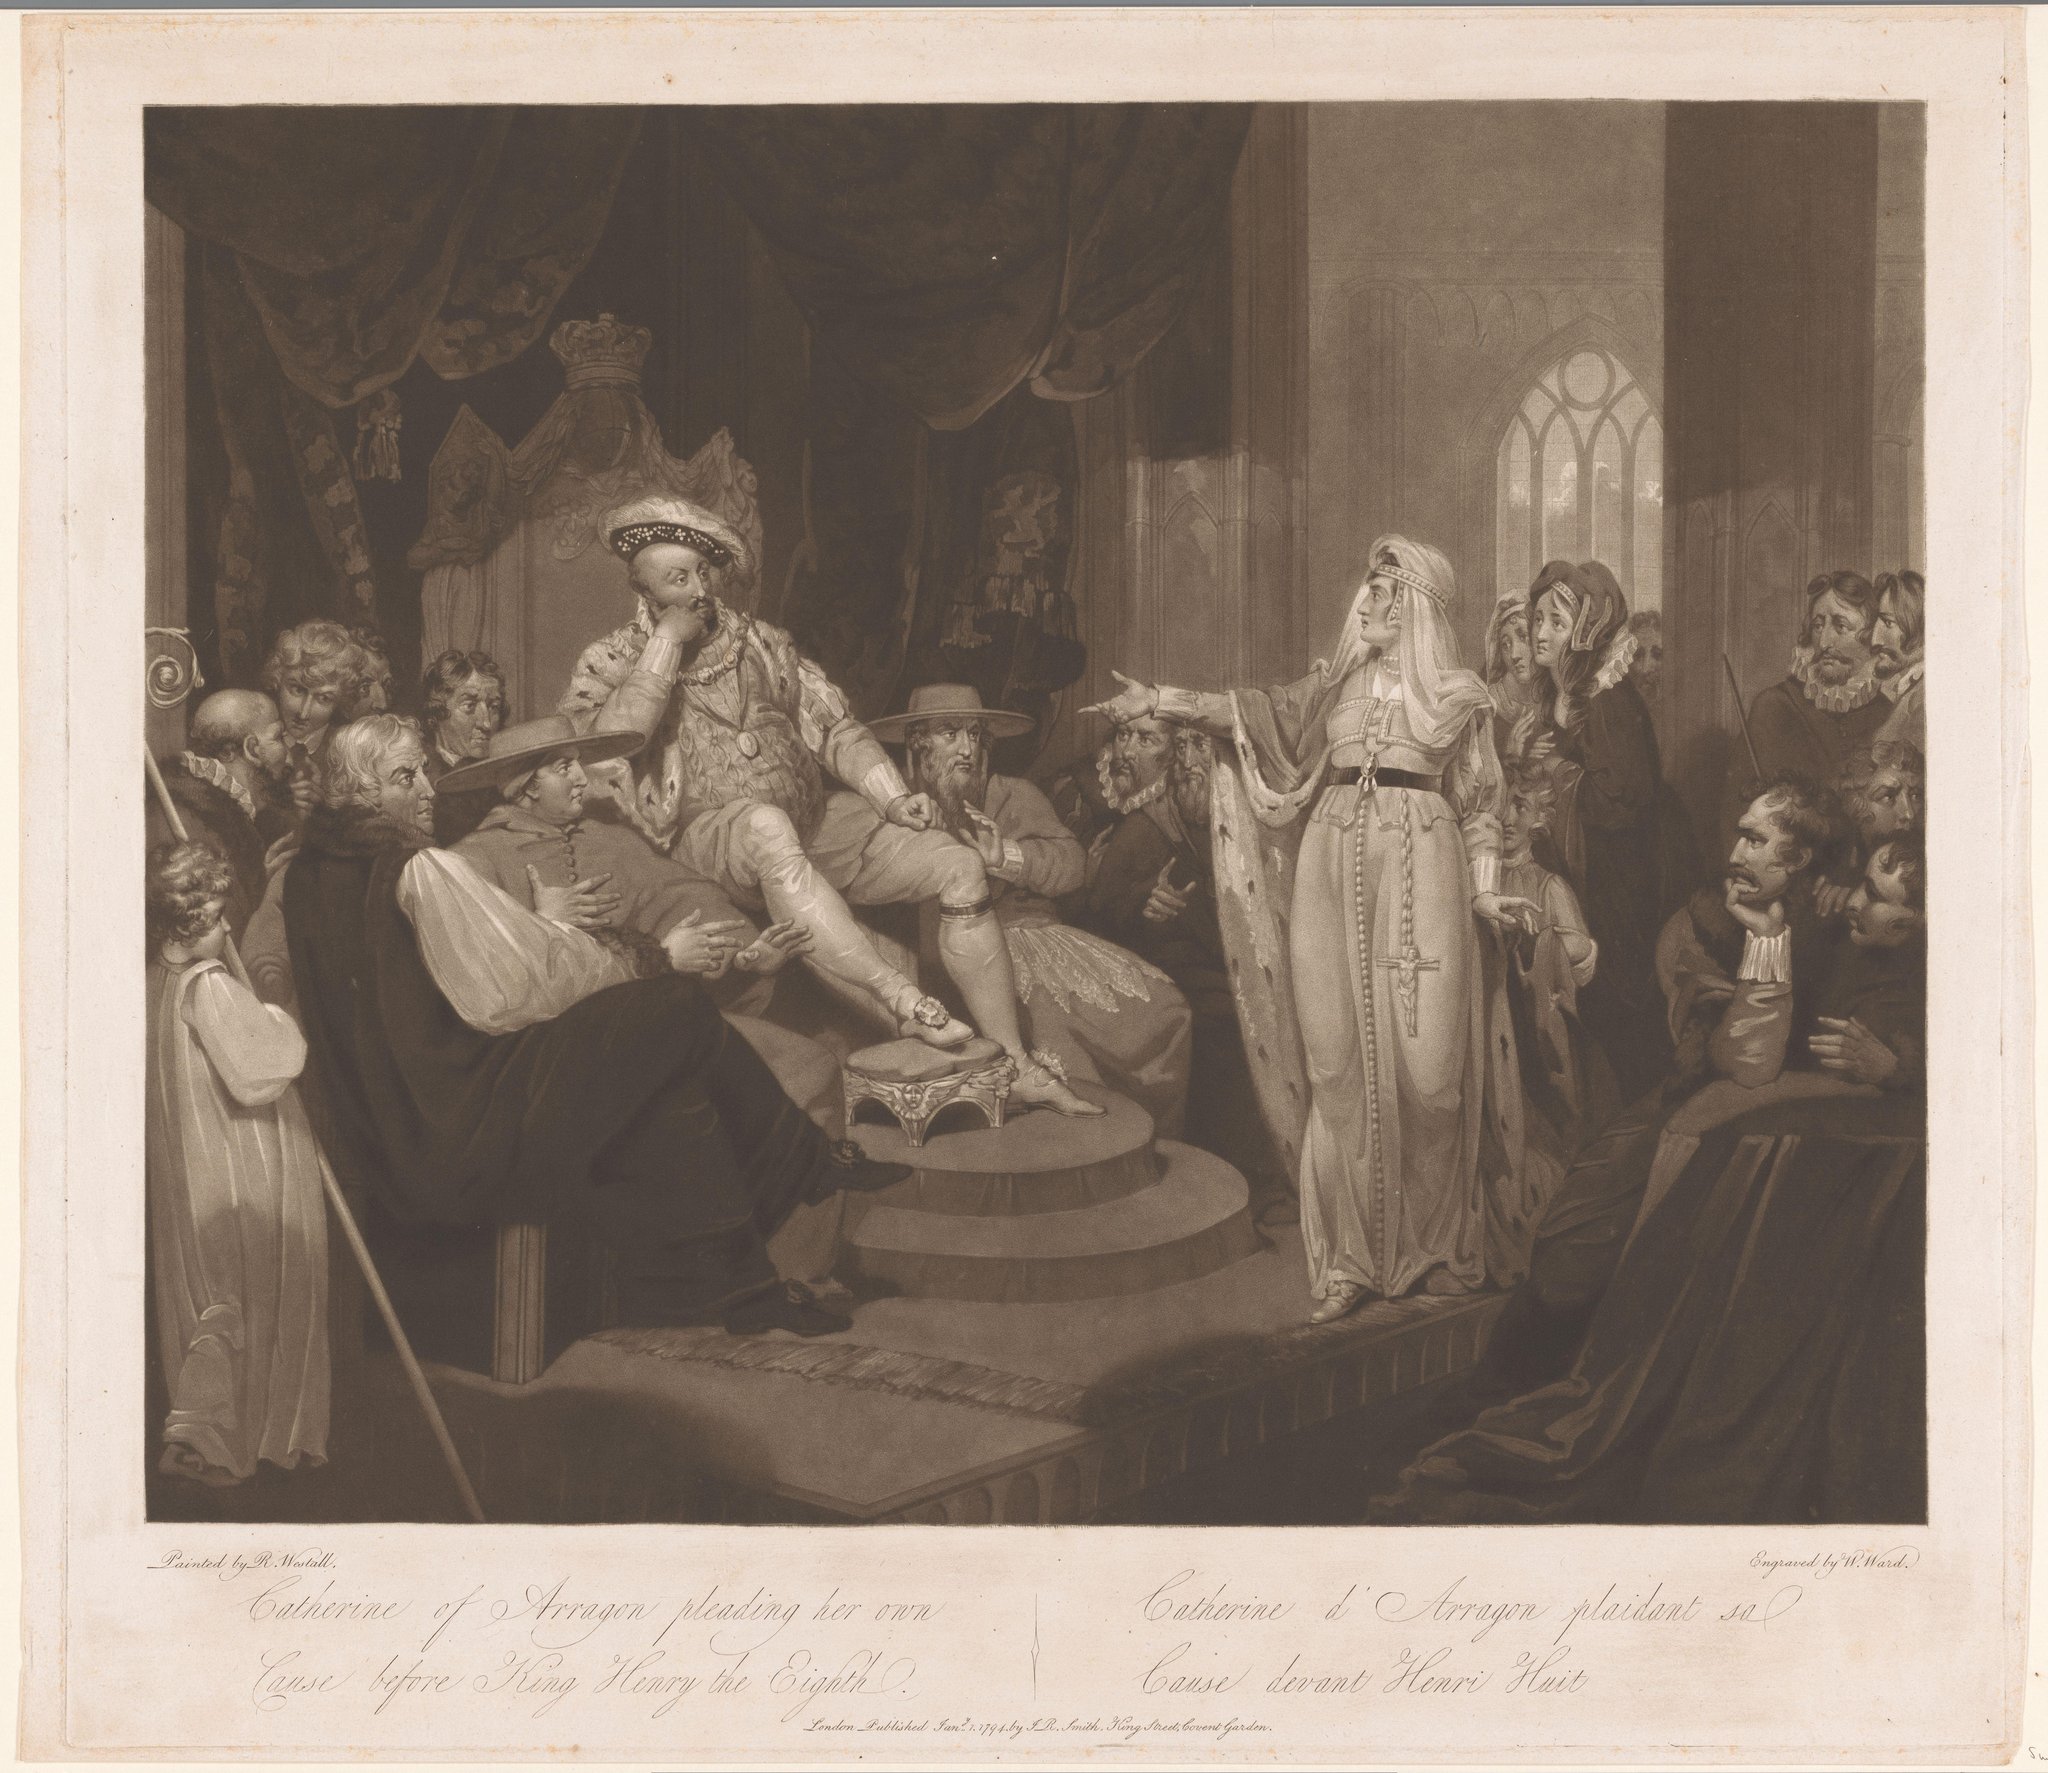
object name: print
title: Catharina van Aragon pleitend voor Hendrik VIII, koning van Engeland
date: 1794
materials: paper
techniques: mezzotint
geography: london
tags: plea, defence, queen, king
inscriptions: collector's mark: Lugt 2233